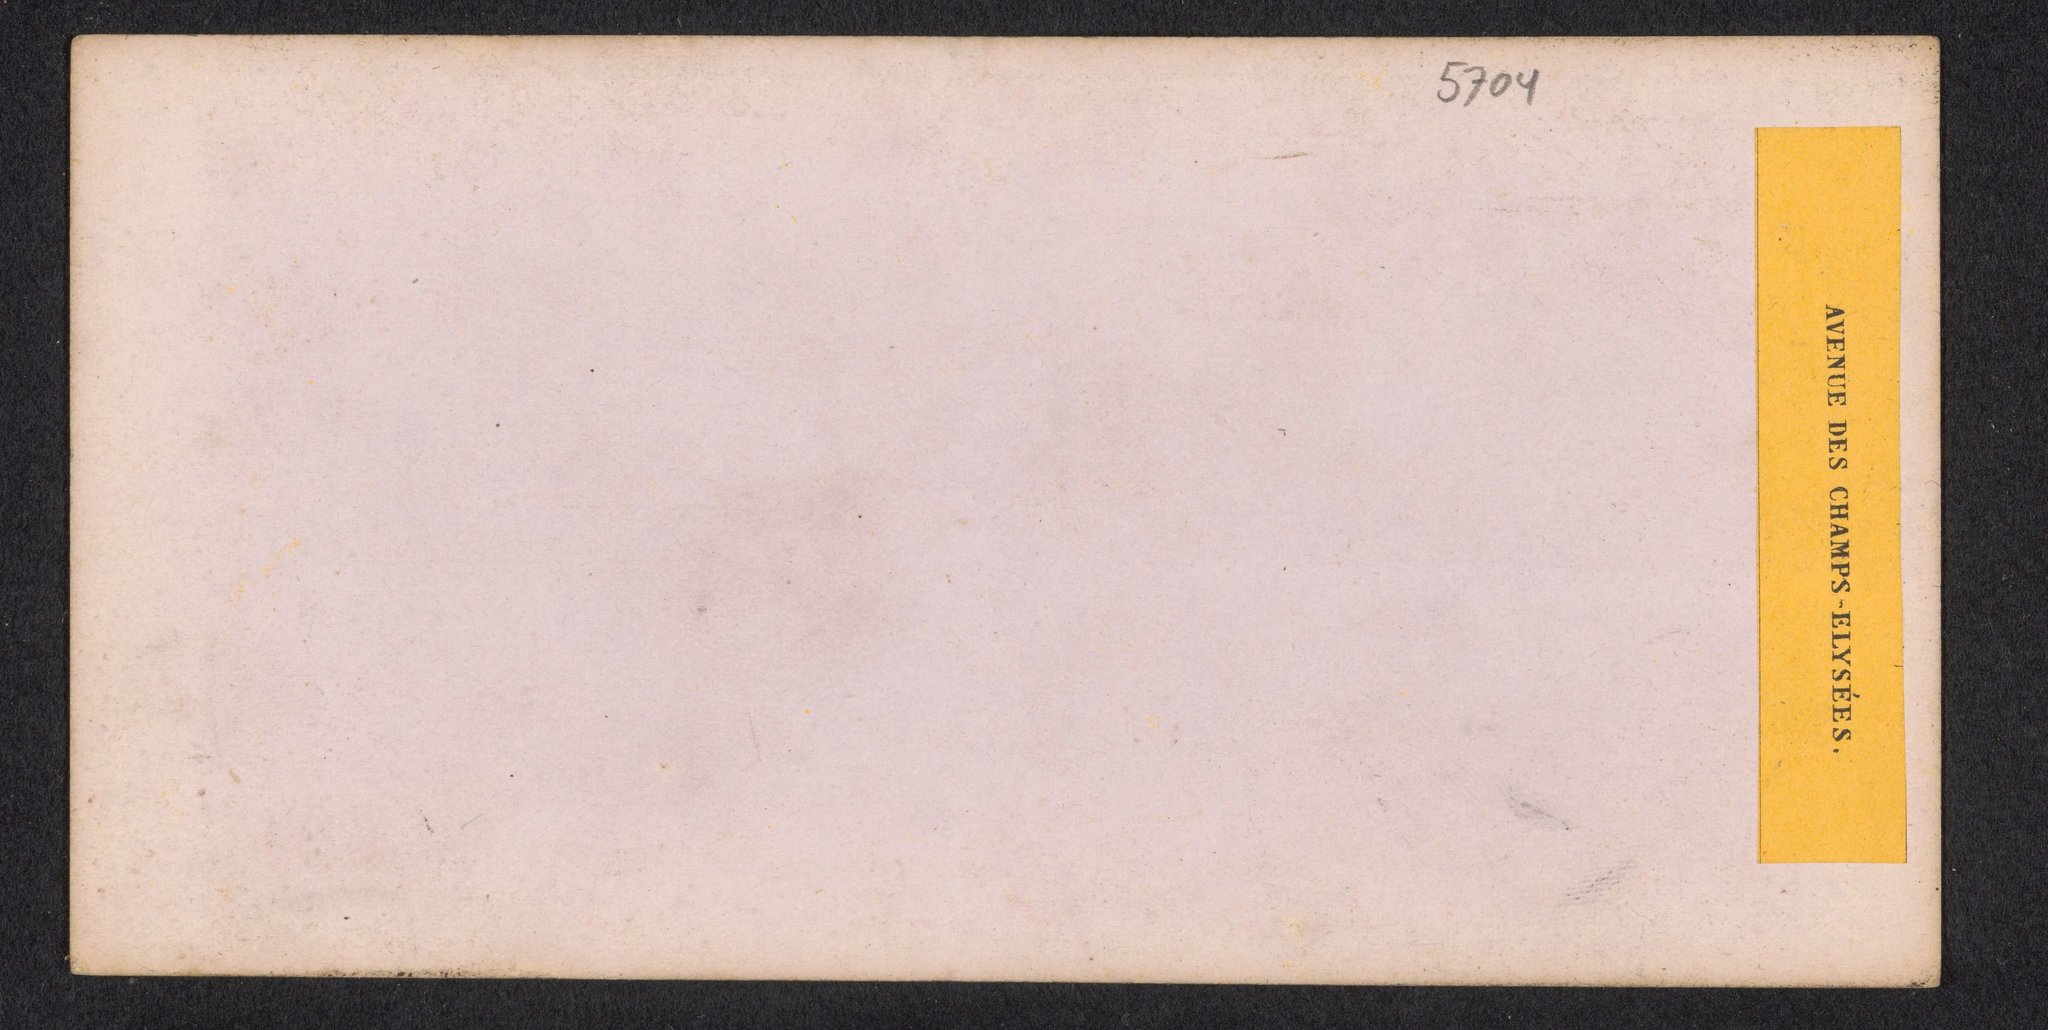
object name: stereograph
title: Gezicht op de Champs-Élysées in Parijs met aan het einde de Arc de Triomphe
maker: Anonymous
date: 1850-1880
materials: cardboard, photographic support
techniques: albumen print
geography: paris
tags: animal traction, animal-drawn vehicle (carriage etc.), triumphal arch, street